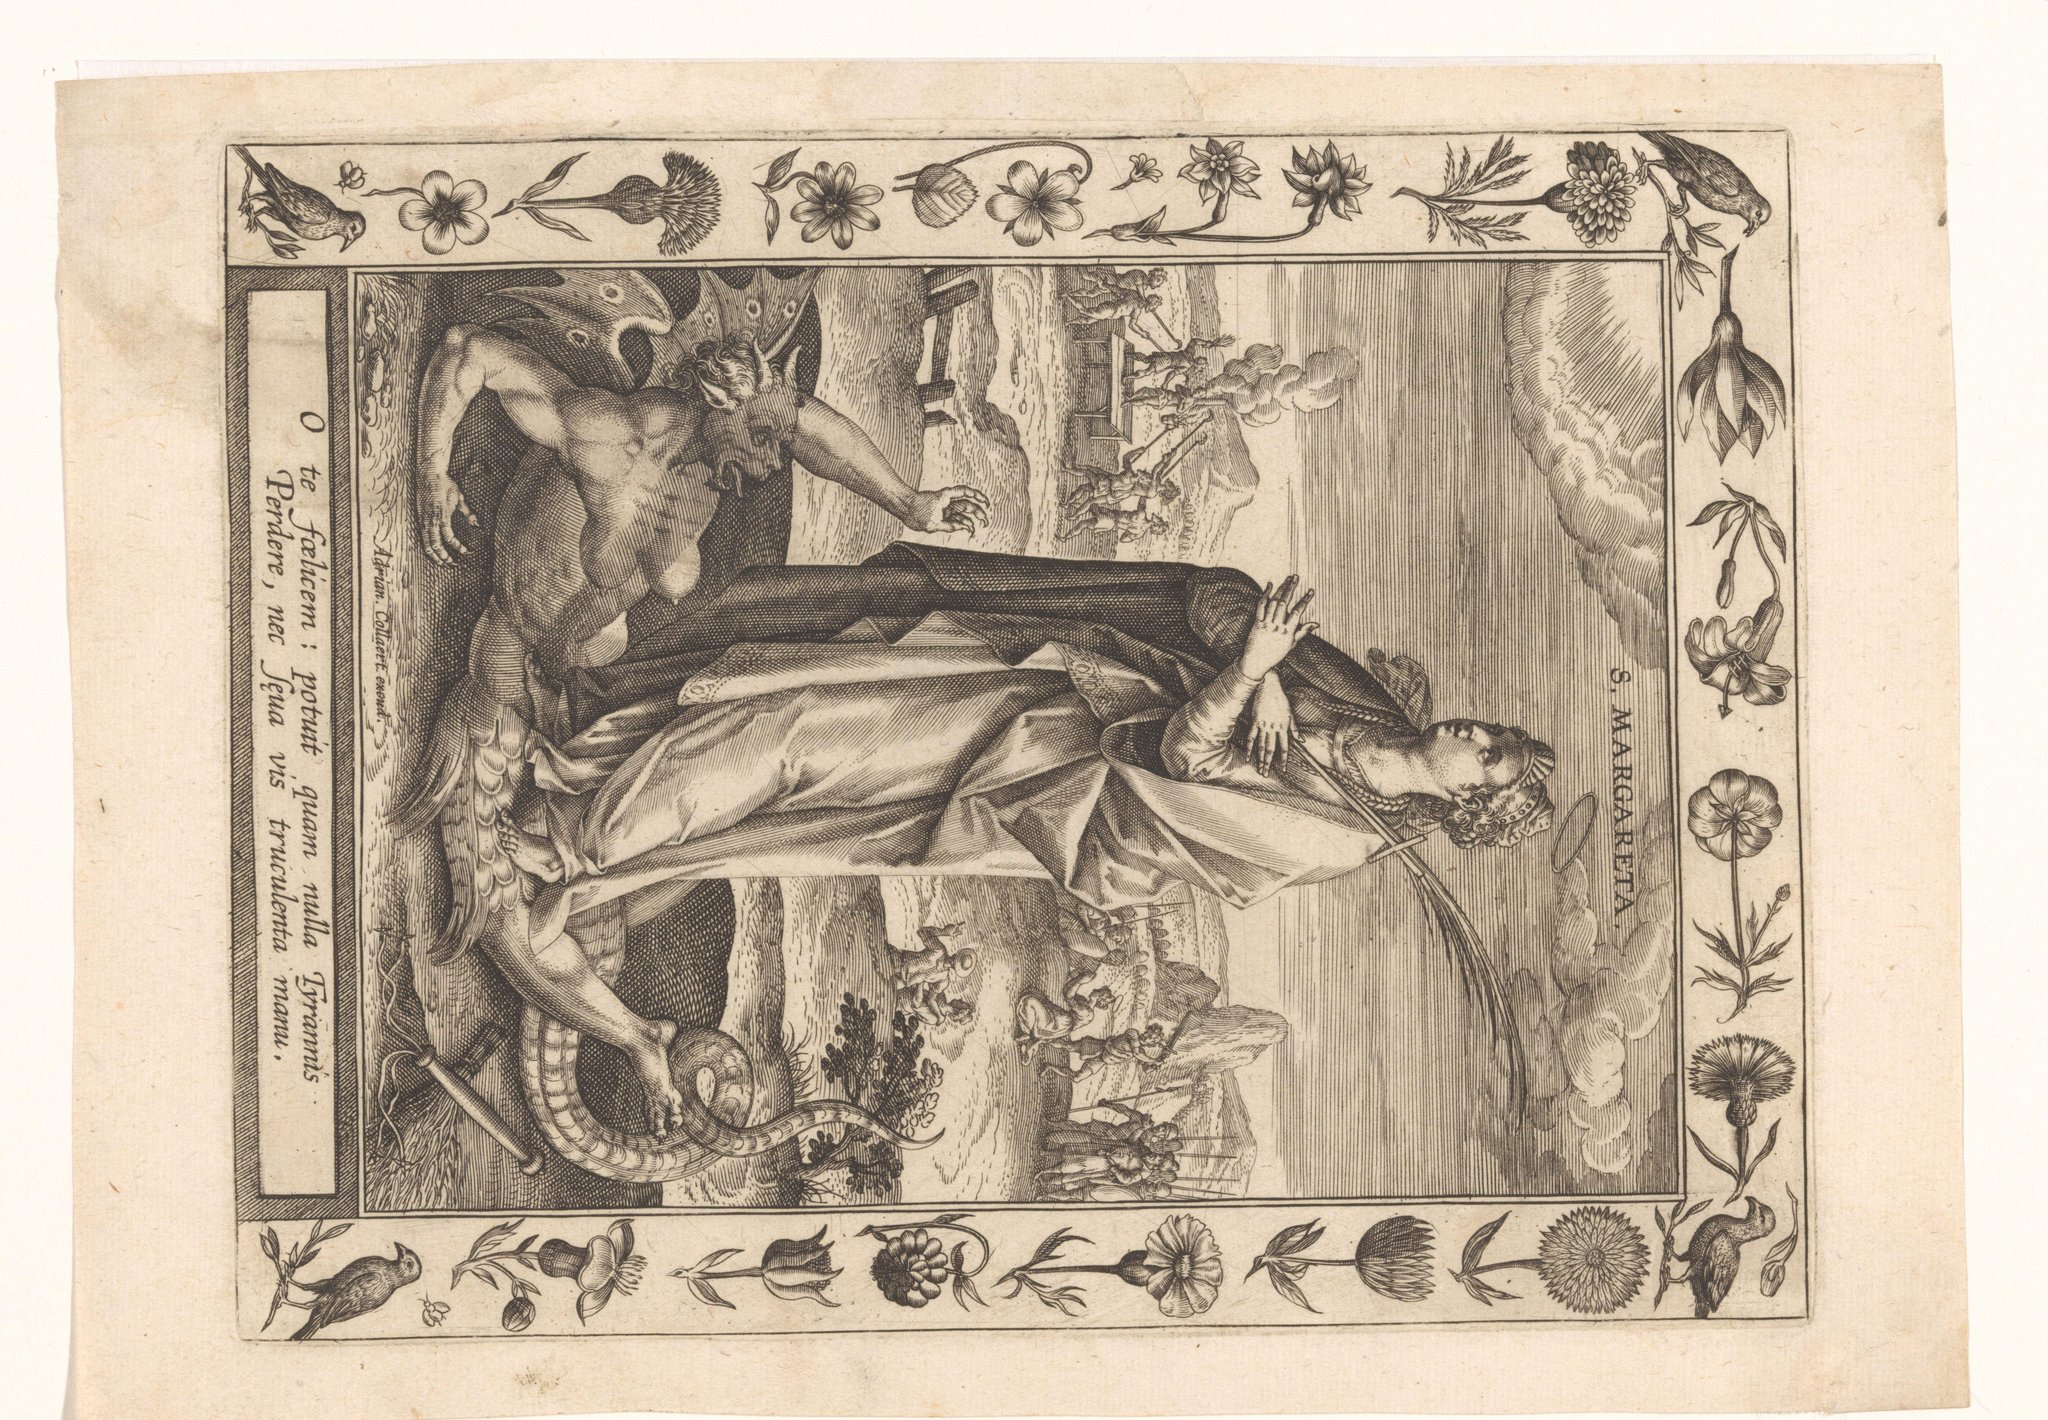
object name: print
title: Heilige Margaretha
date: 1590-1610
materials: paper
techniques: engraving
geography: antwerp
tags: flowers, birds, the virgin martyr margaret of antioch; possible attributes: cross, crown, dragon (under feet or on chain), (chaplet of) pearls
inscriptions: collector's mark: Lugt 3751, collector's mark: Lugt 2760, collector's mark: Lugt 2228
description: Heilige Margaretha. Onderdeel van een serie van 24 voorstellingen van vrouwelijke martelaren (martyrologium). De voorstellingen zijn voorzien van randen met bloemen en dieren.